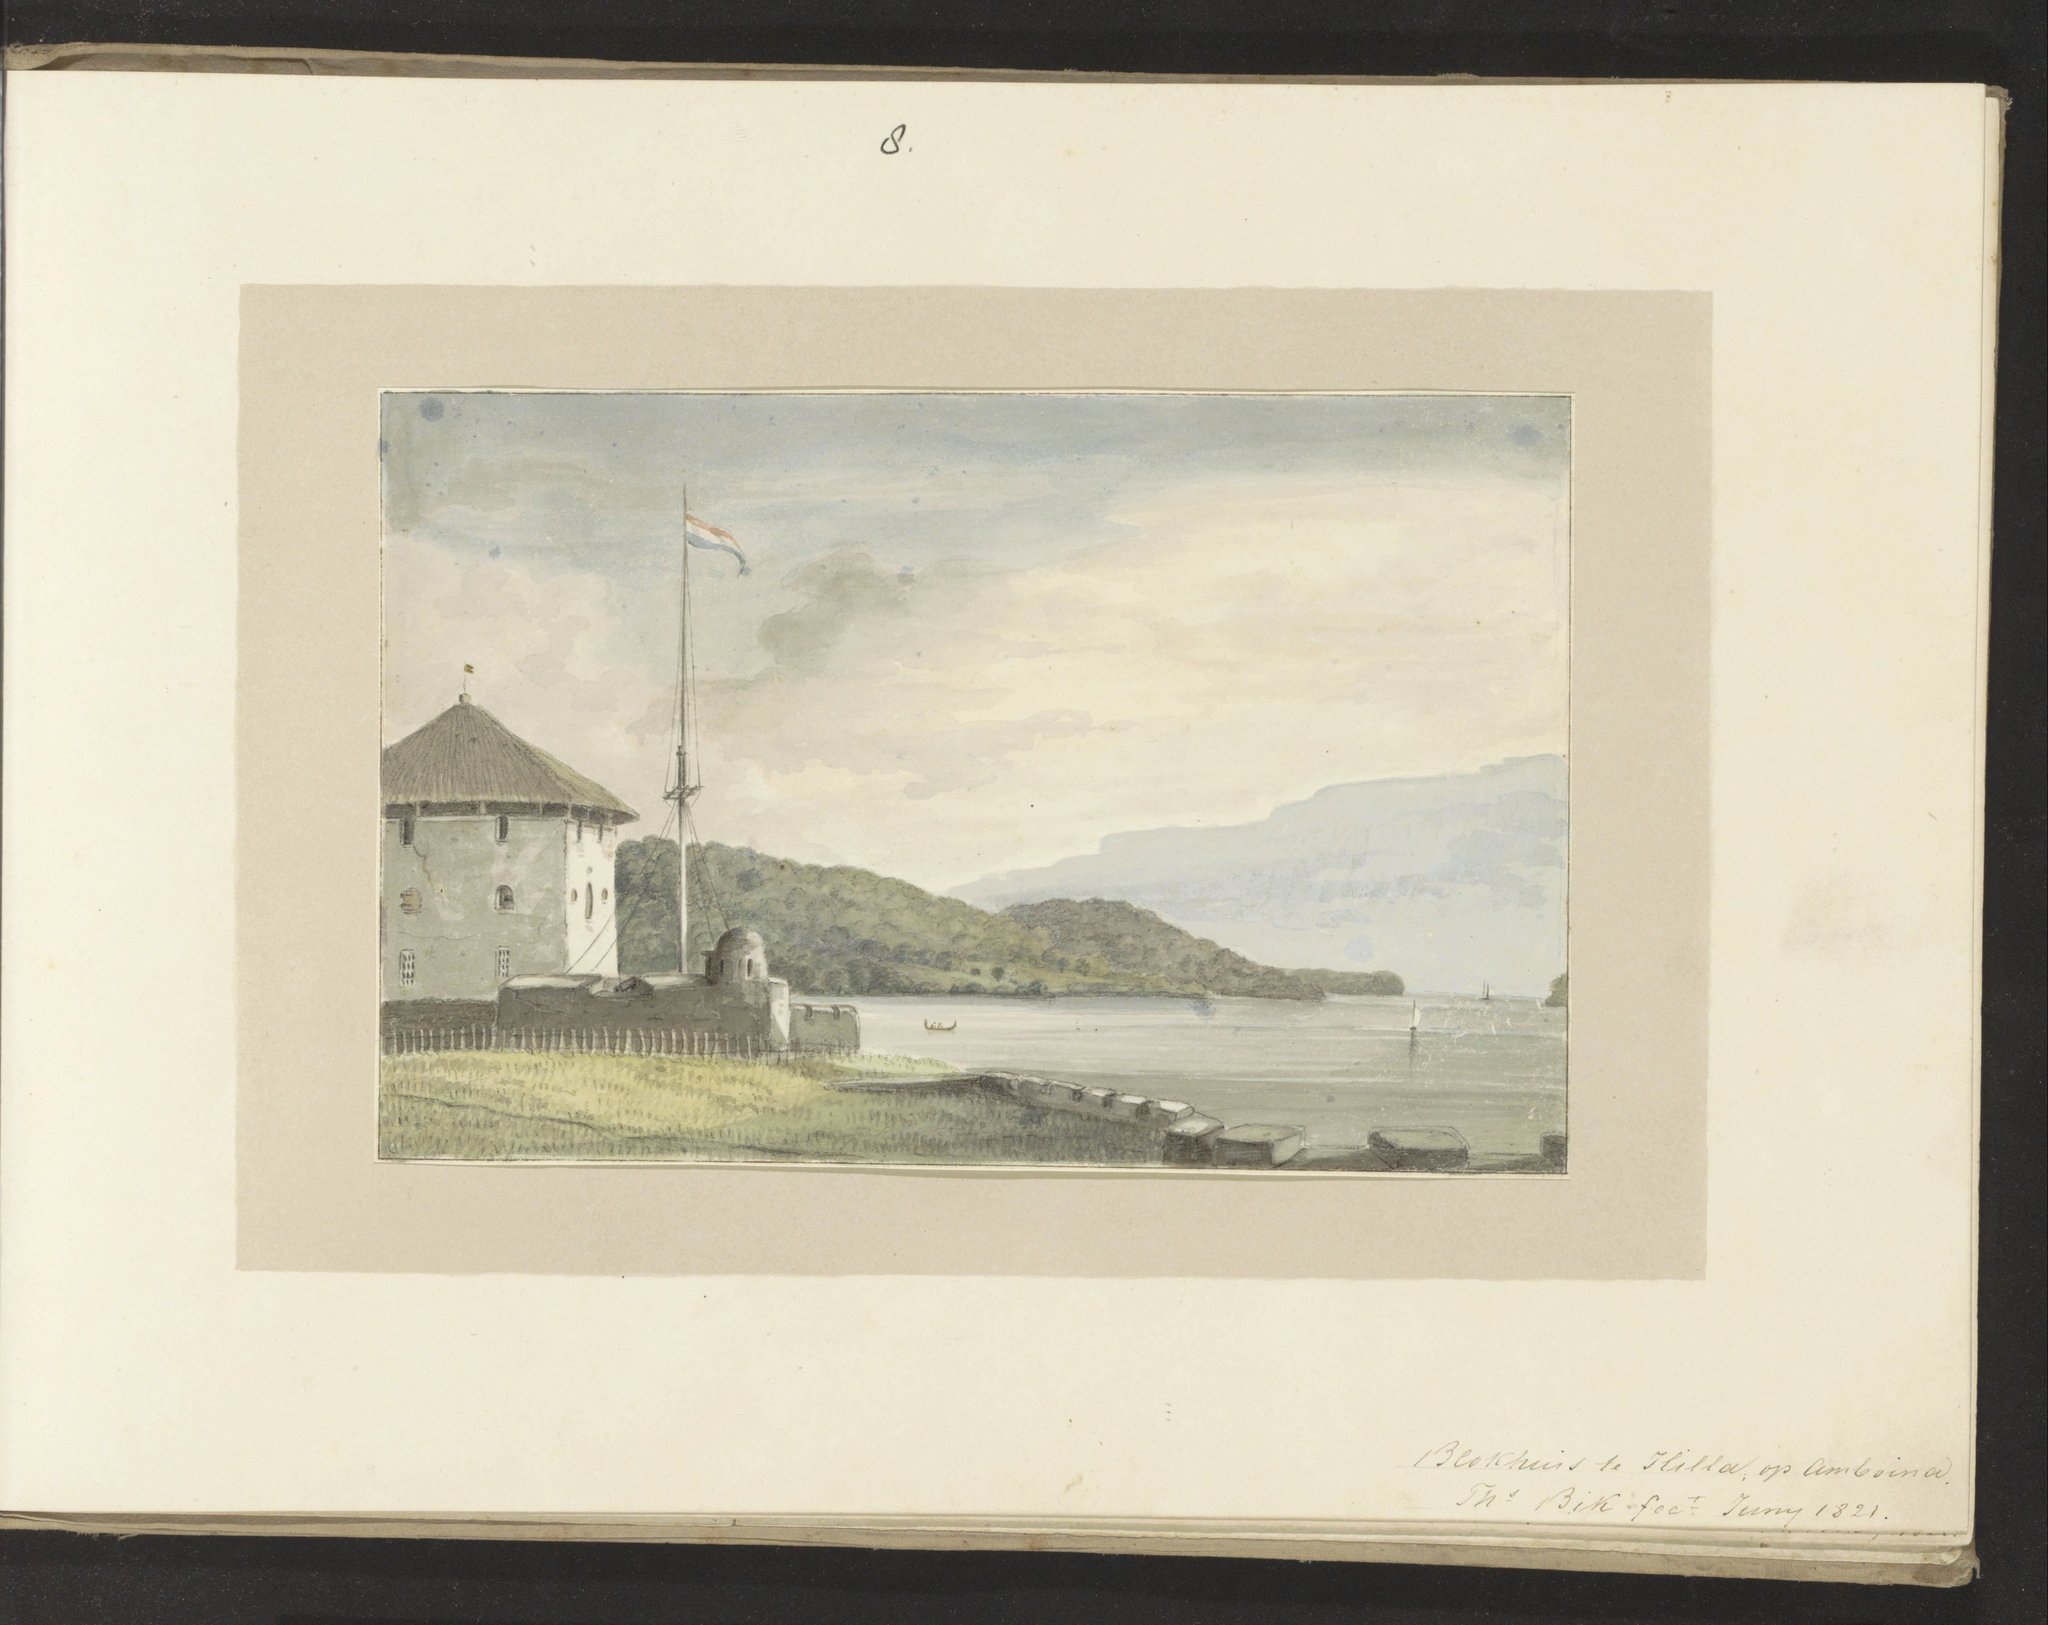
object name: album leaf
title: Blokhuis te Hila op Ambon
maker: jannes theodorus bik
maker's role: draughtsman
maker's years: 1796-1872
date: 1806-1821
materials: chalk, ink, paper, pencil, watercolor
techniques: brush, pen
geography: ambon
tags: architecture, coast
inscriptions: signature and date: ‘Th. Bik fect Juny 1821.’, annotation: ‘Blokhuis te Hilla, op Amboina’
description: Blad 8 uit een album met 14 tekeningen en een prent.